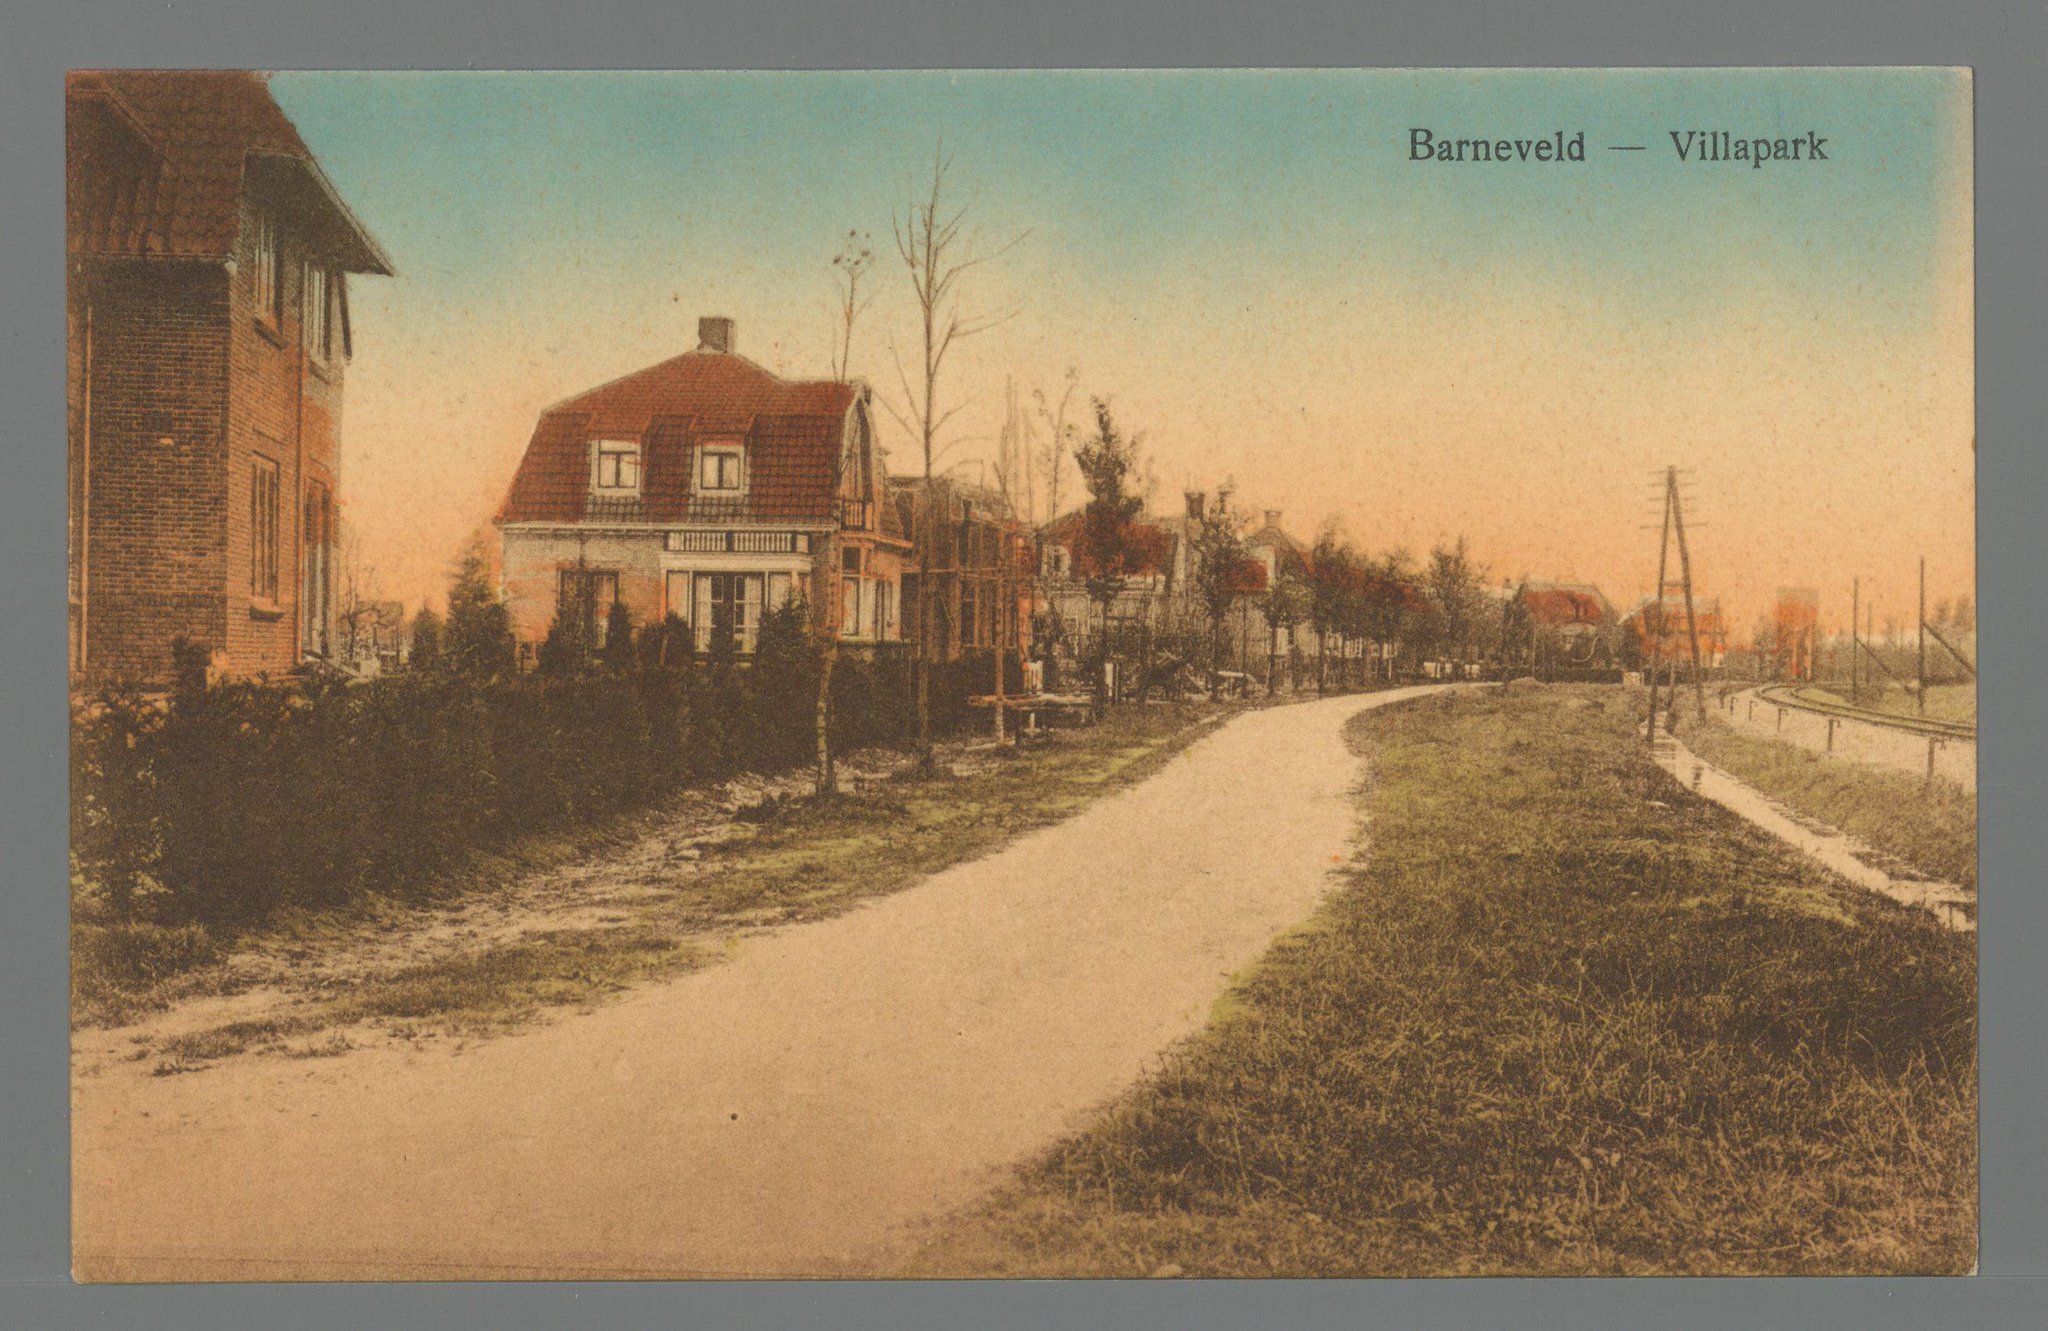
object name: ansichtkaart, prentbriefkaart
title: Barneveld. Villapark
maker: Anonymous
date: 1905-1930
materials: cardboard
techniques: photograph, lithograph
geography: barneveld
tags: villa, street